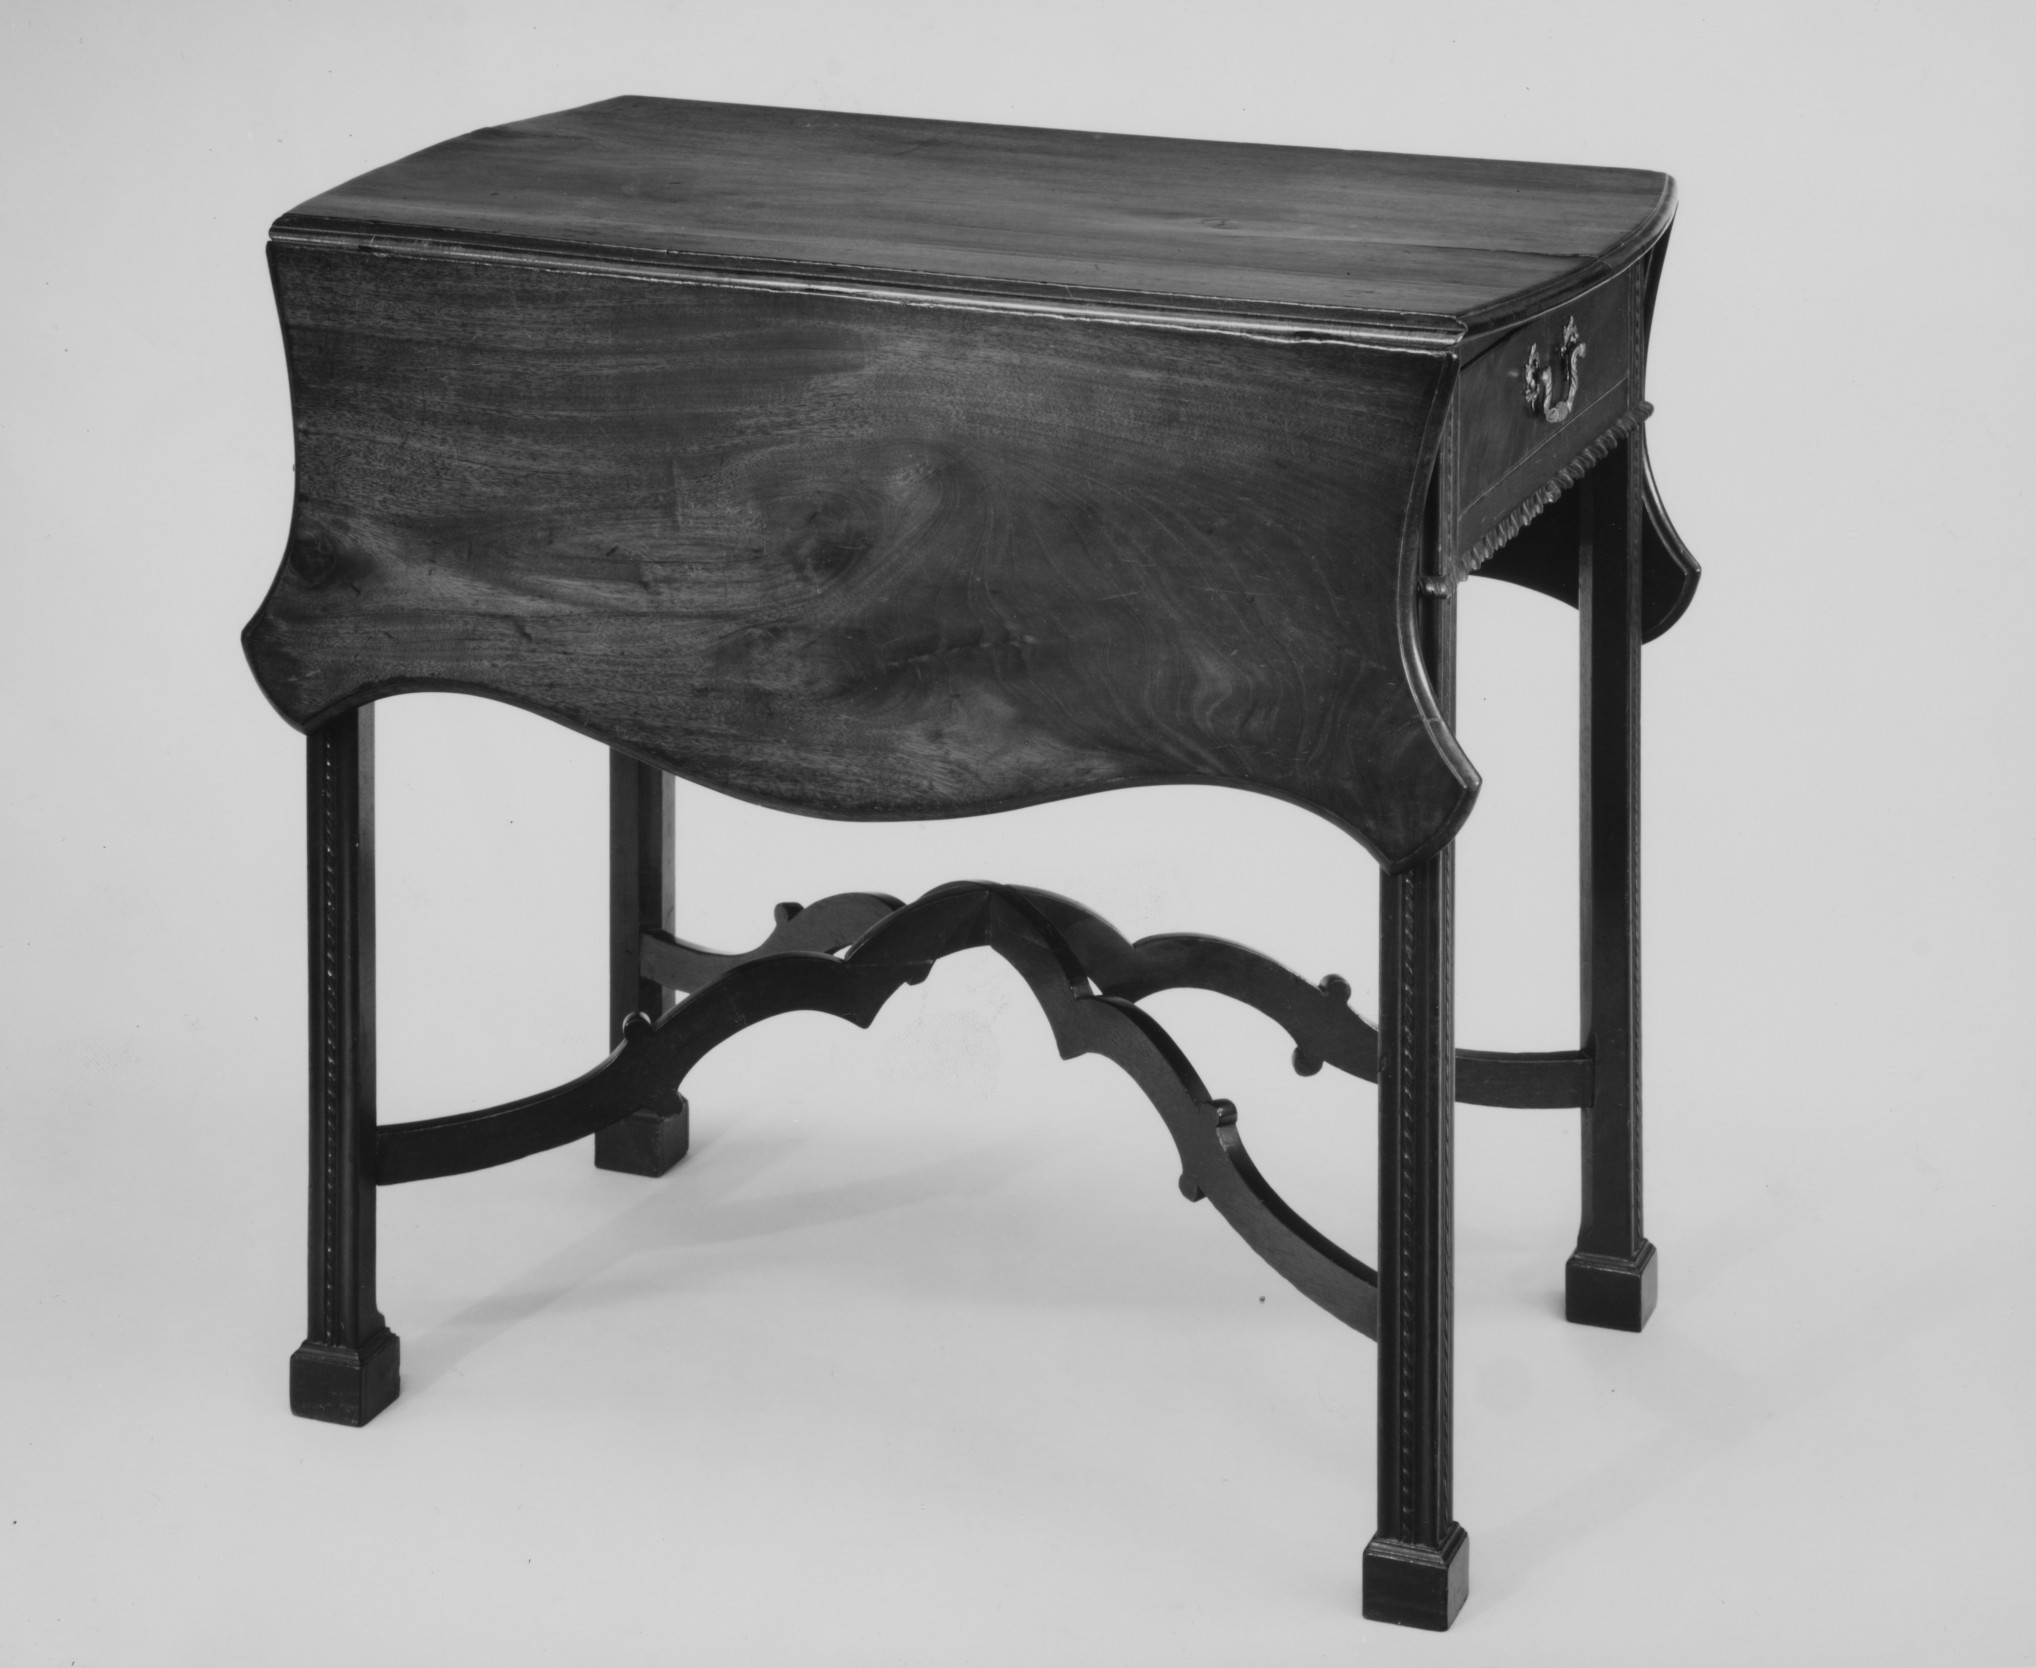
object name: pembroke table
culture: american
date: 1765-1790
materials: wood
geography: united states